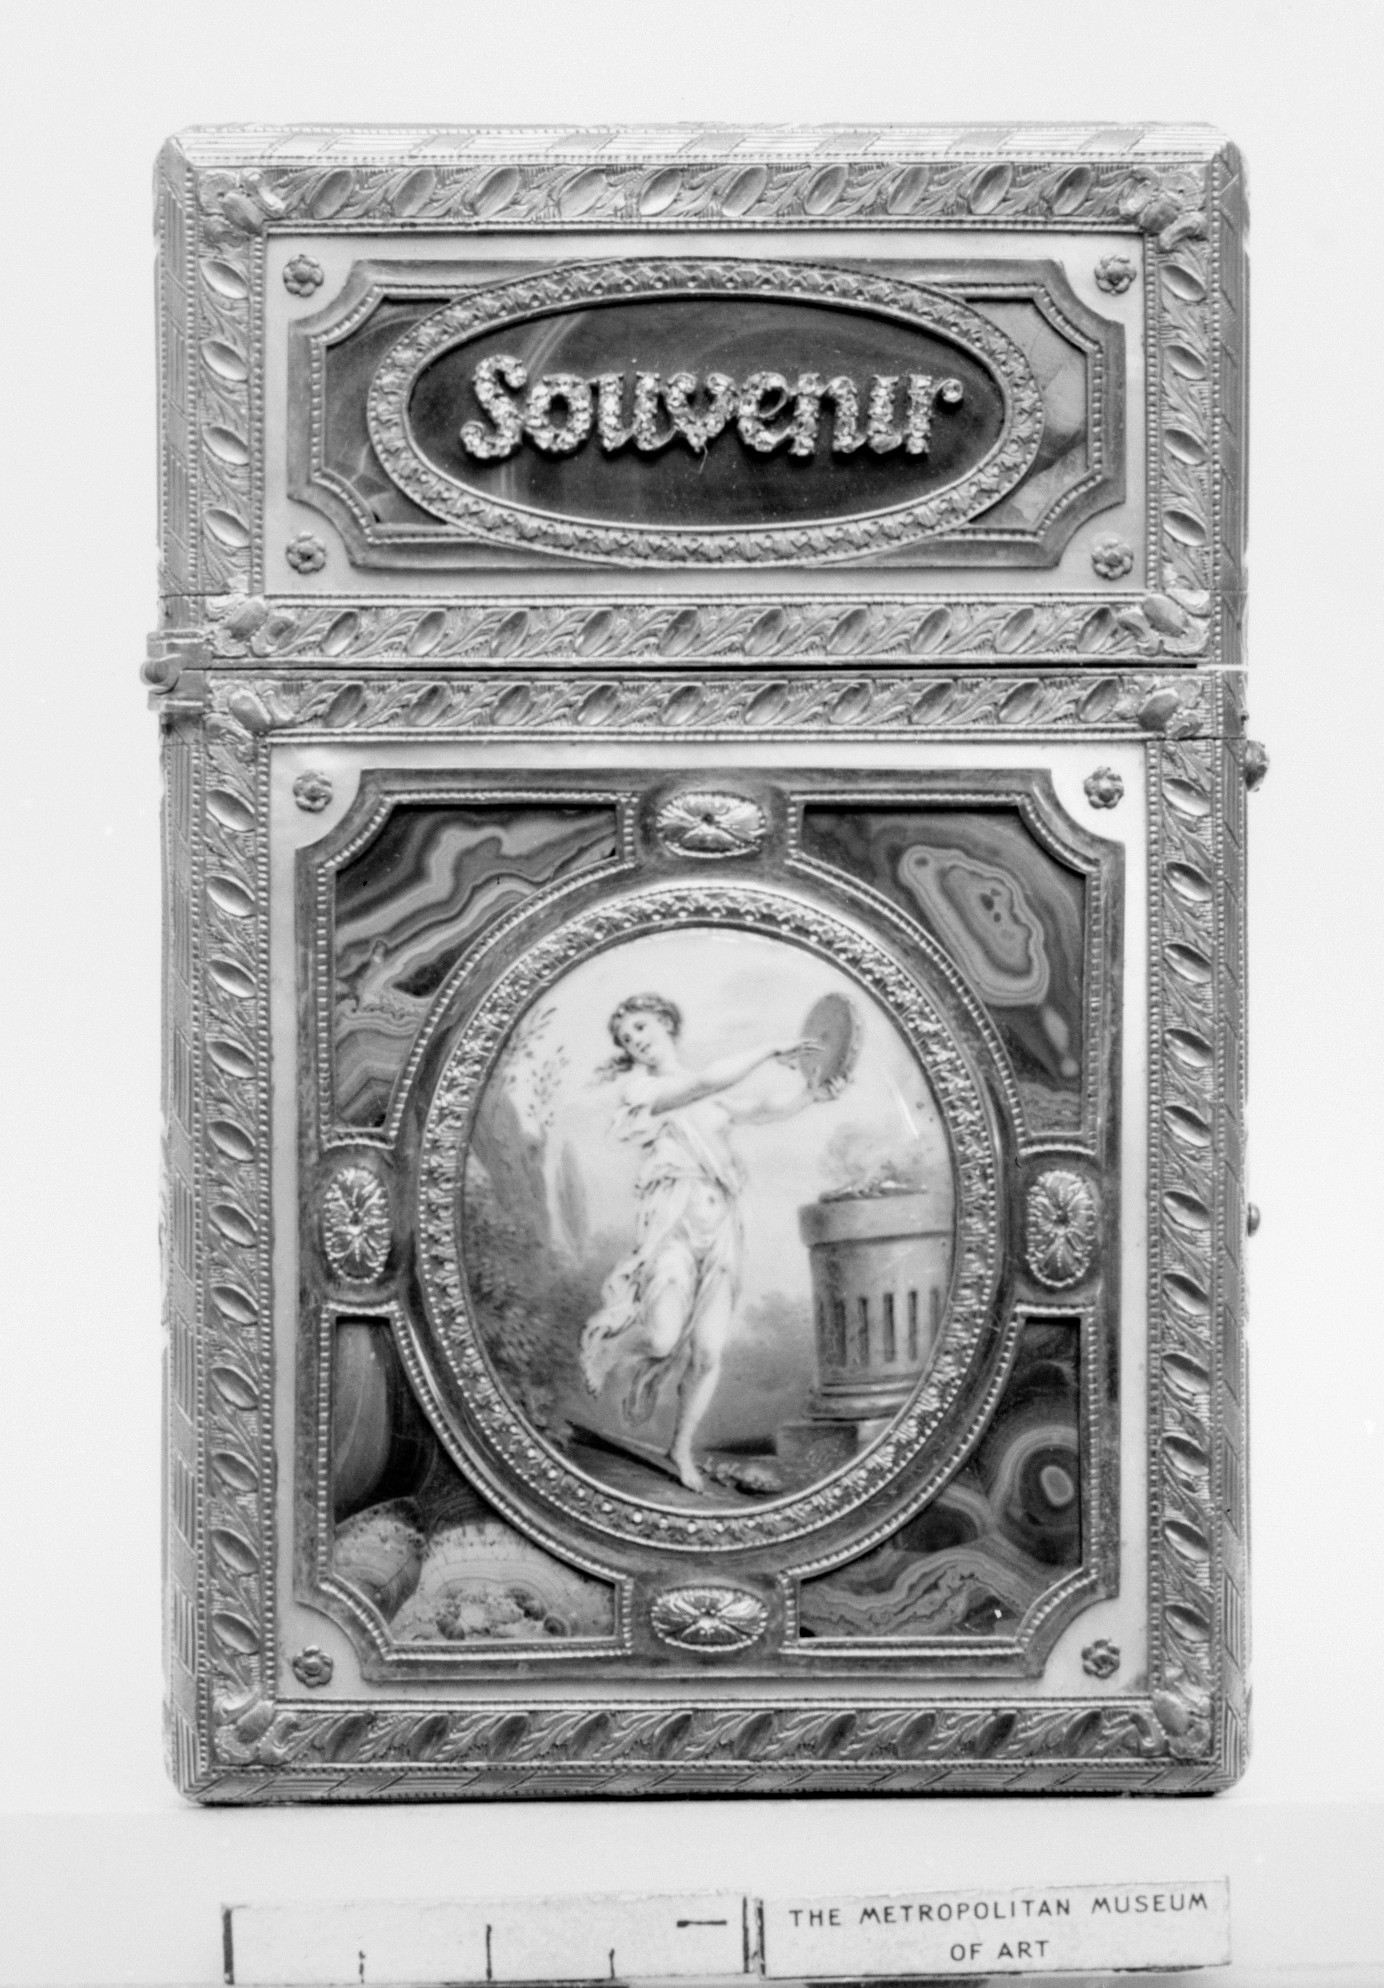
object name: souvenir, painting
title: Souvenir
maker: louis cousin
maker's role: maker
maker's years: 1766-1781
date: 1774-1775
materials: diamond, gold, ivory, mother of pearl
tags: women